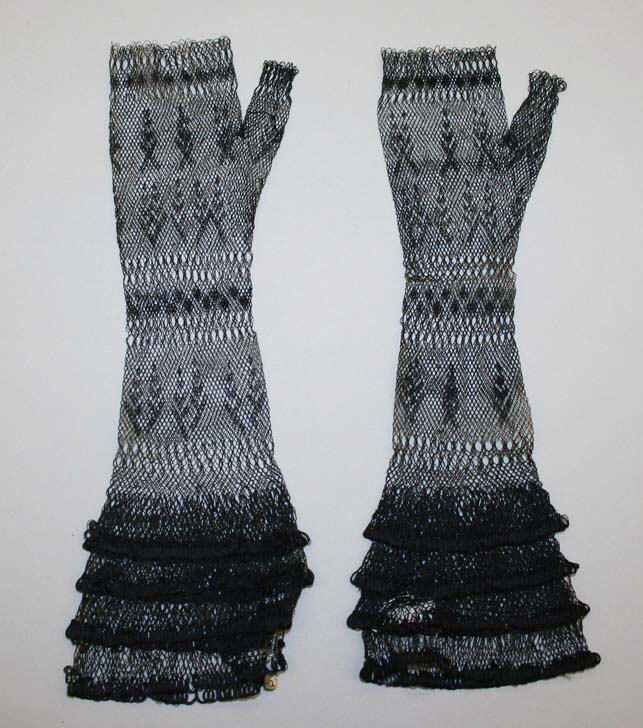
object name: mitt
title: Mitts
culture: american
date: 1801-1825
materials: silk